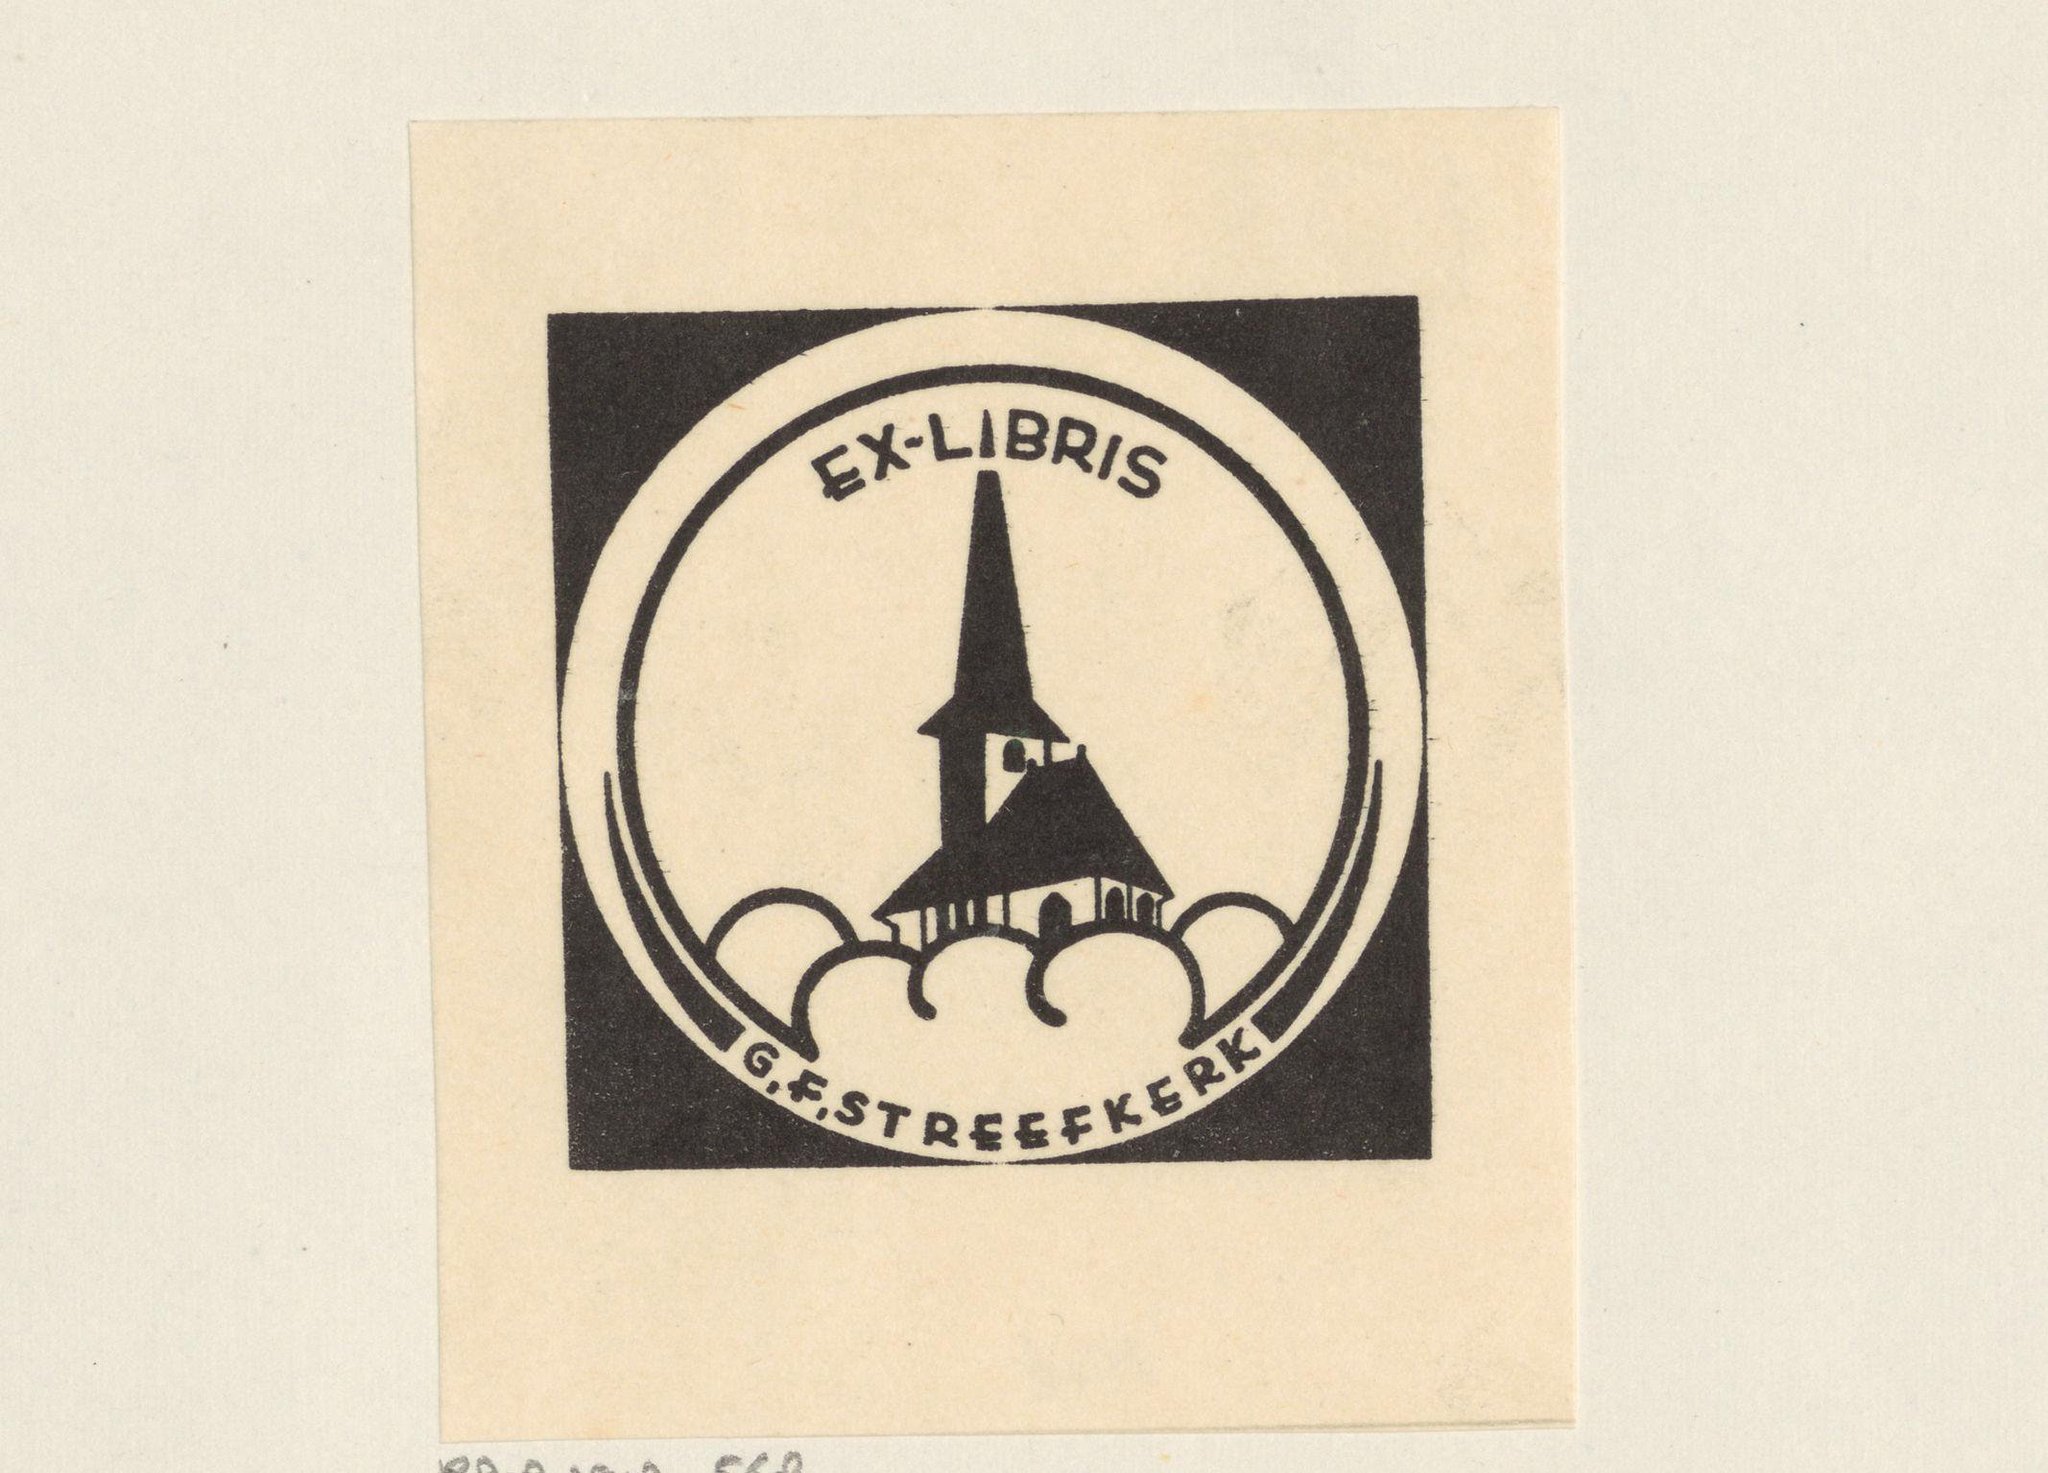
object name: bookplate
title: Ex libris van G.F. Streefkerk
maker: Anonymous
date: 1900-1999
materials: paper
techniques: printing block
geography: netherlands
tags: the place of worship and its equipment ~ christian churches, clouds